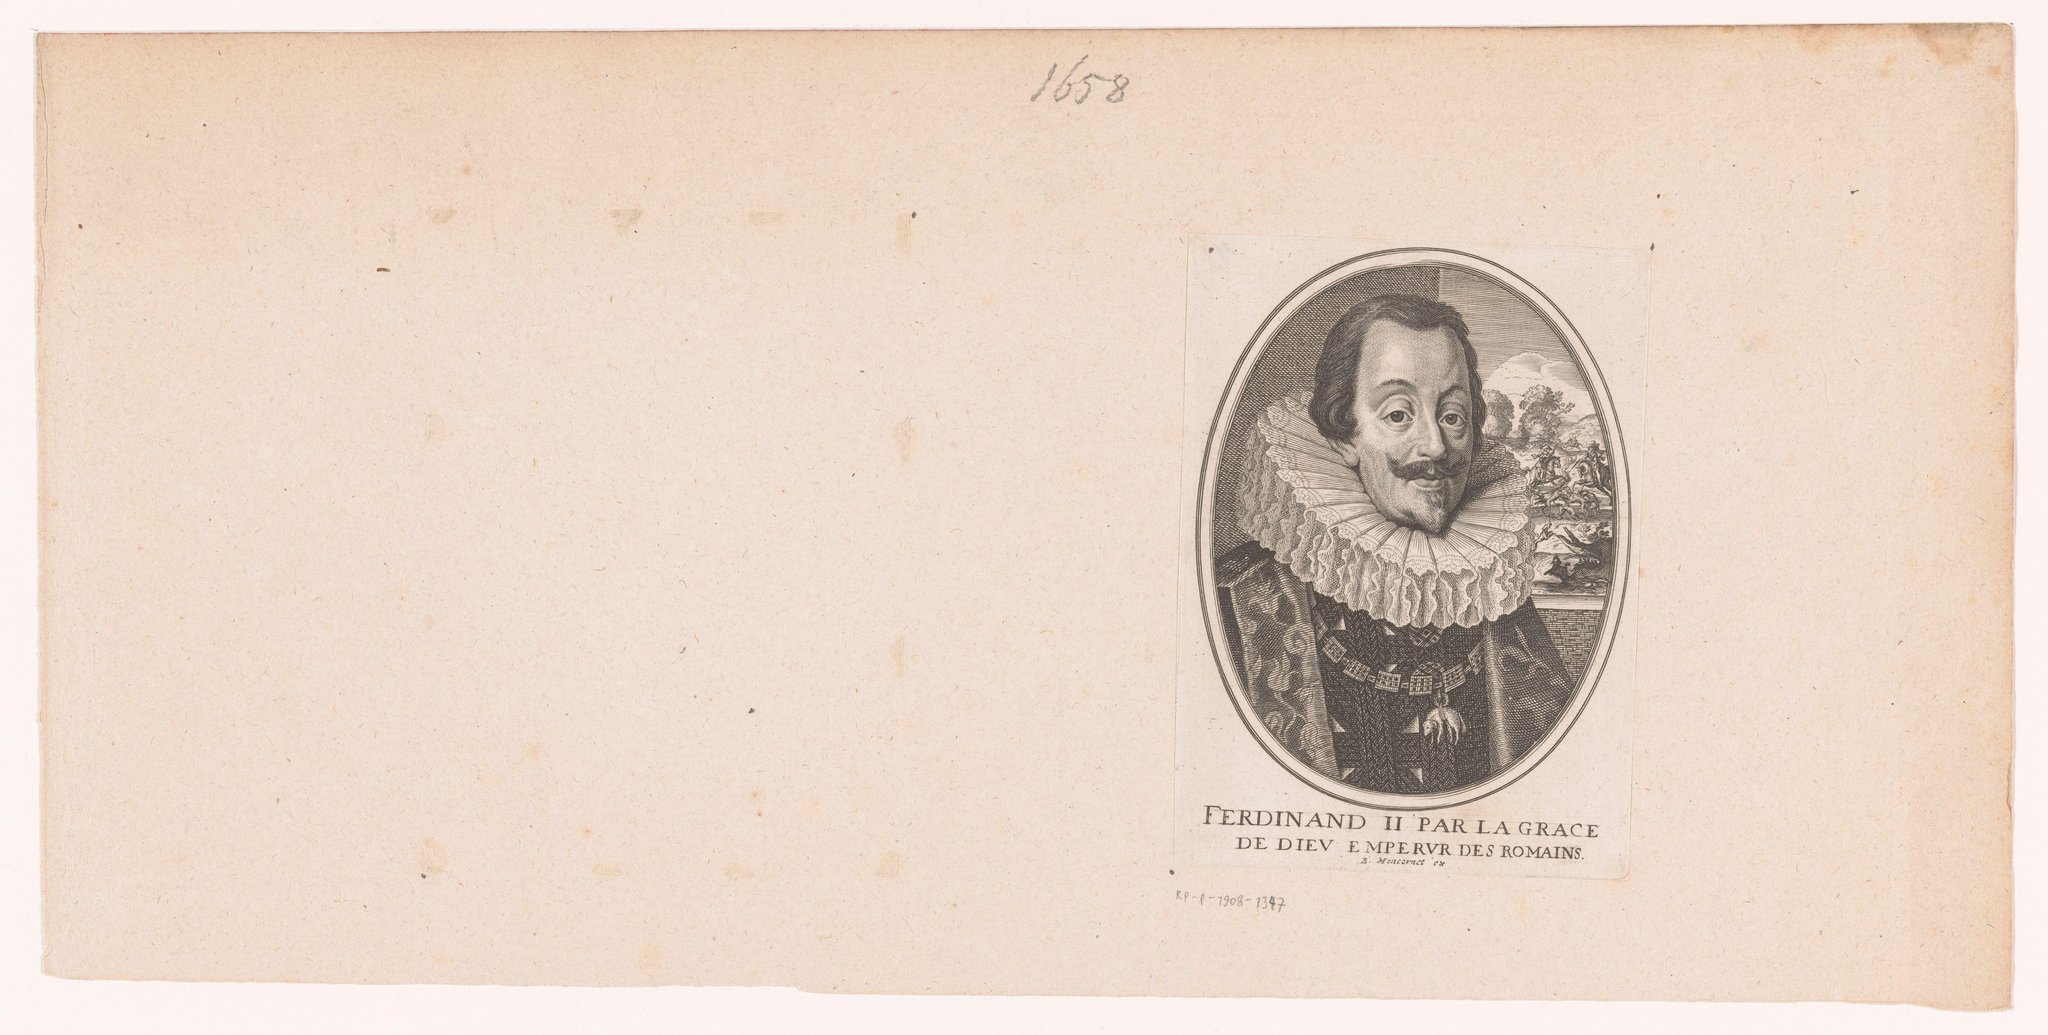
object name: print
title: Portret van keizer Ferdinand II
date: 1619-1668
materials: paper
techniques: engraving, etching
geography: paris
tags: ferdinand ii (duits keizer), historical persons, emperor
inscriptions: collector's mark: Lugt 2228